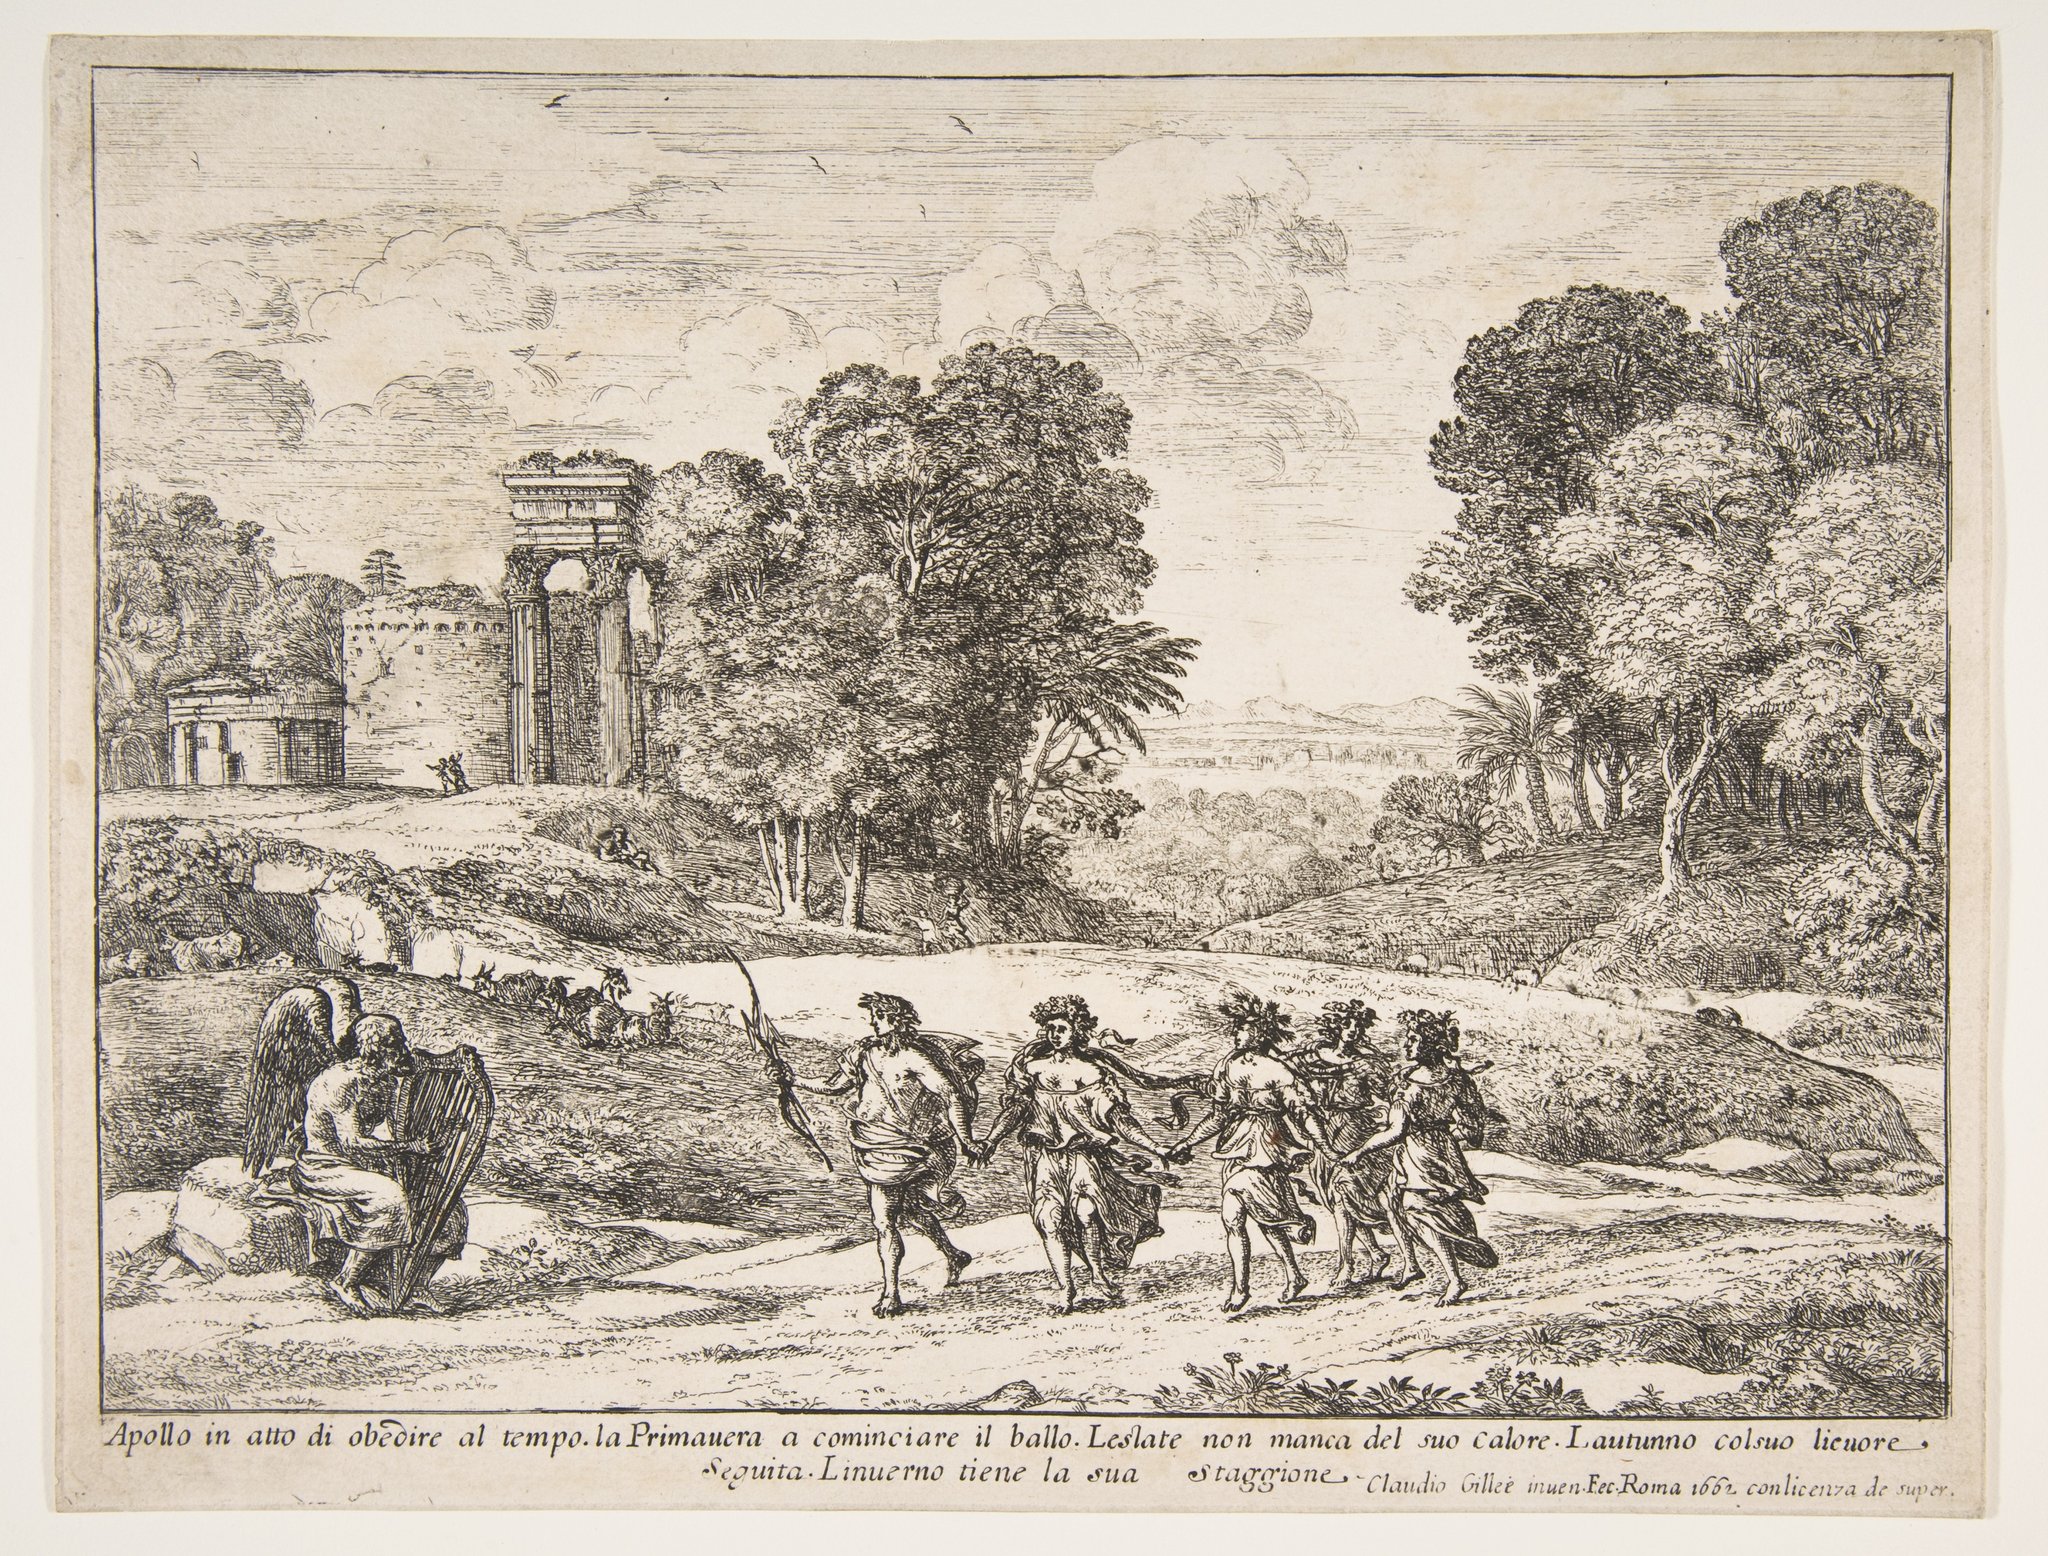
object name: print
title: Time, Apollo and the Seasons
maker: claude lorrain (claude gellée)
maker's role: artist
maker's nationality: french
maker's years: 1604-1682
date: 1662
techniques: etching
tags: apollo